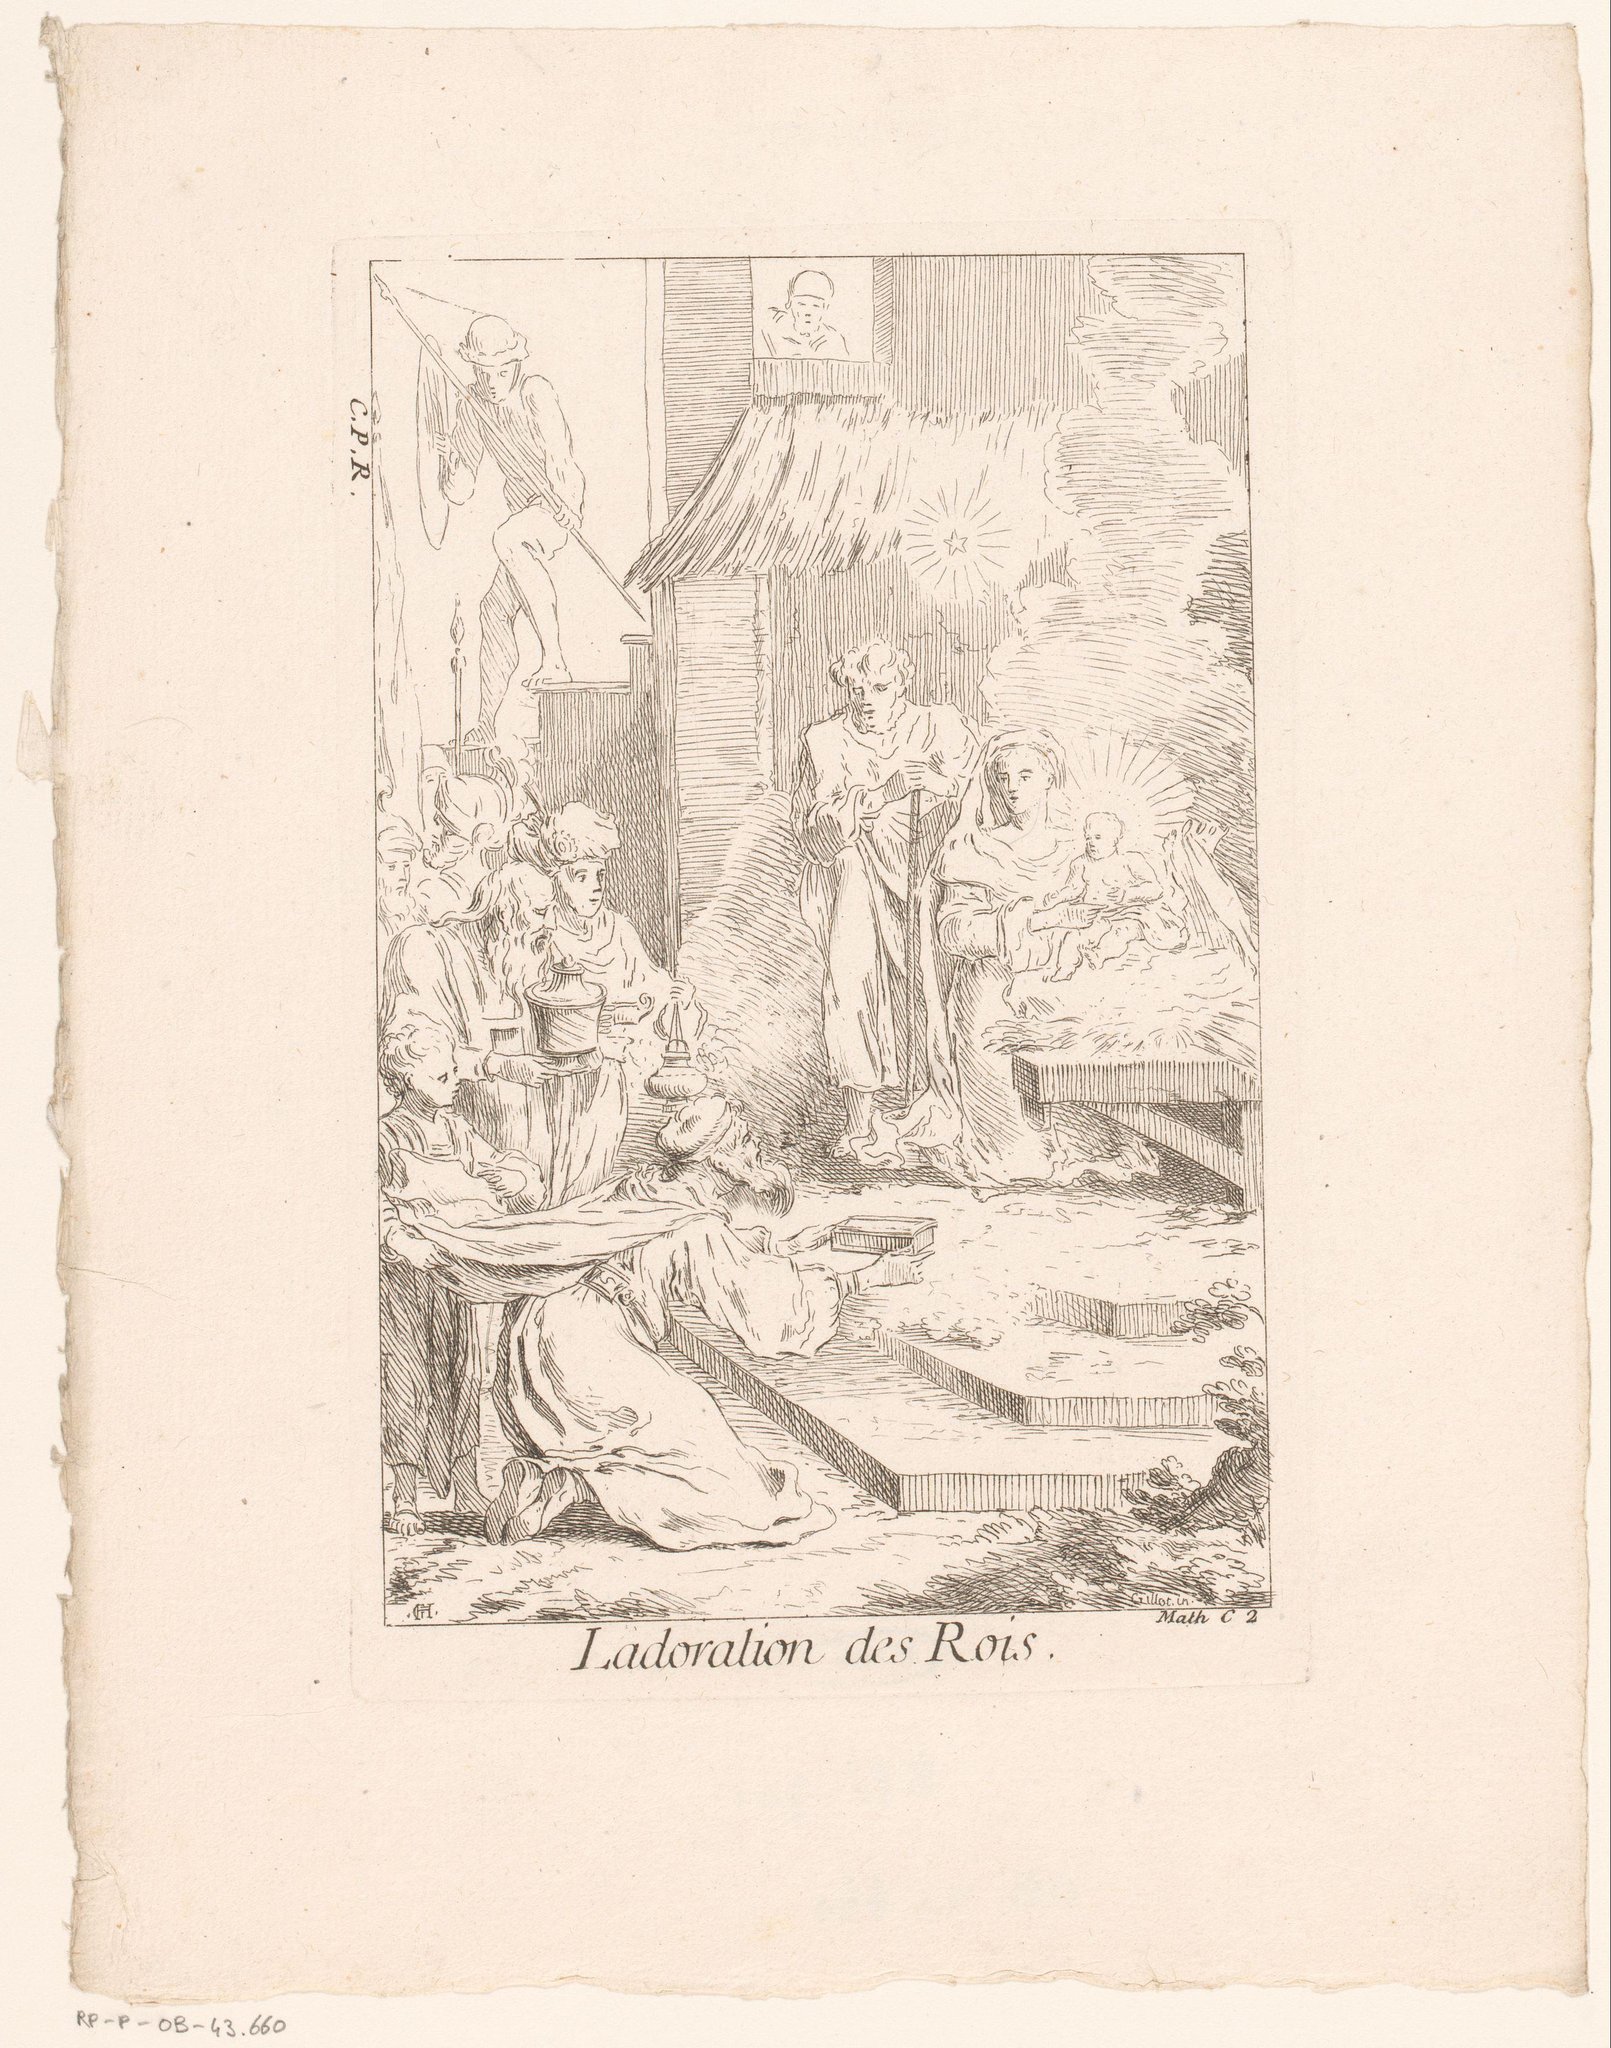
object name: print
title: Ladoration des Rois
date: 1705-1732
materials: paper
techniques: etching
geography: france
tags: adoration of the kings: the wise men present their gifts to the christ-child (gold, frankincense and myrrh)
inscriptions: collector's mark: Lugt 2228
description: Maakt deel uit van een serie met zestig prenten met als thema het leven van Christus.